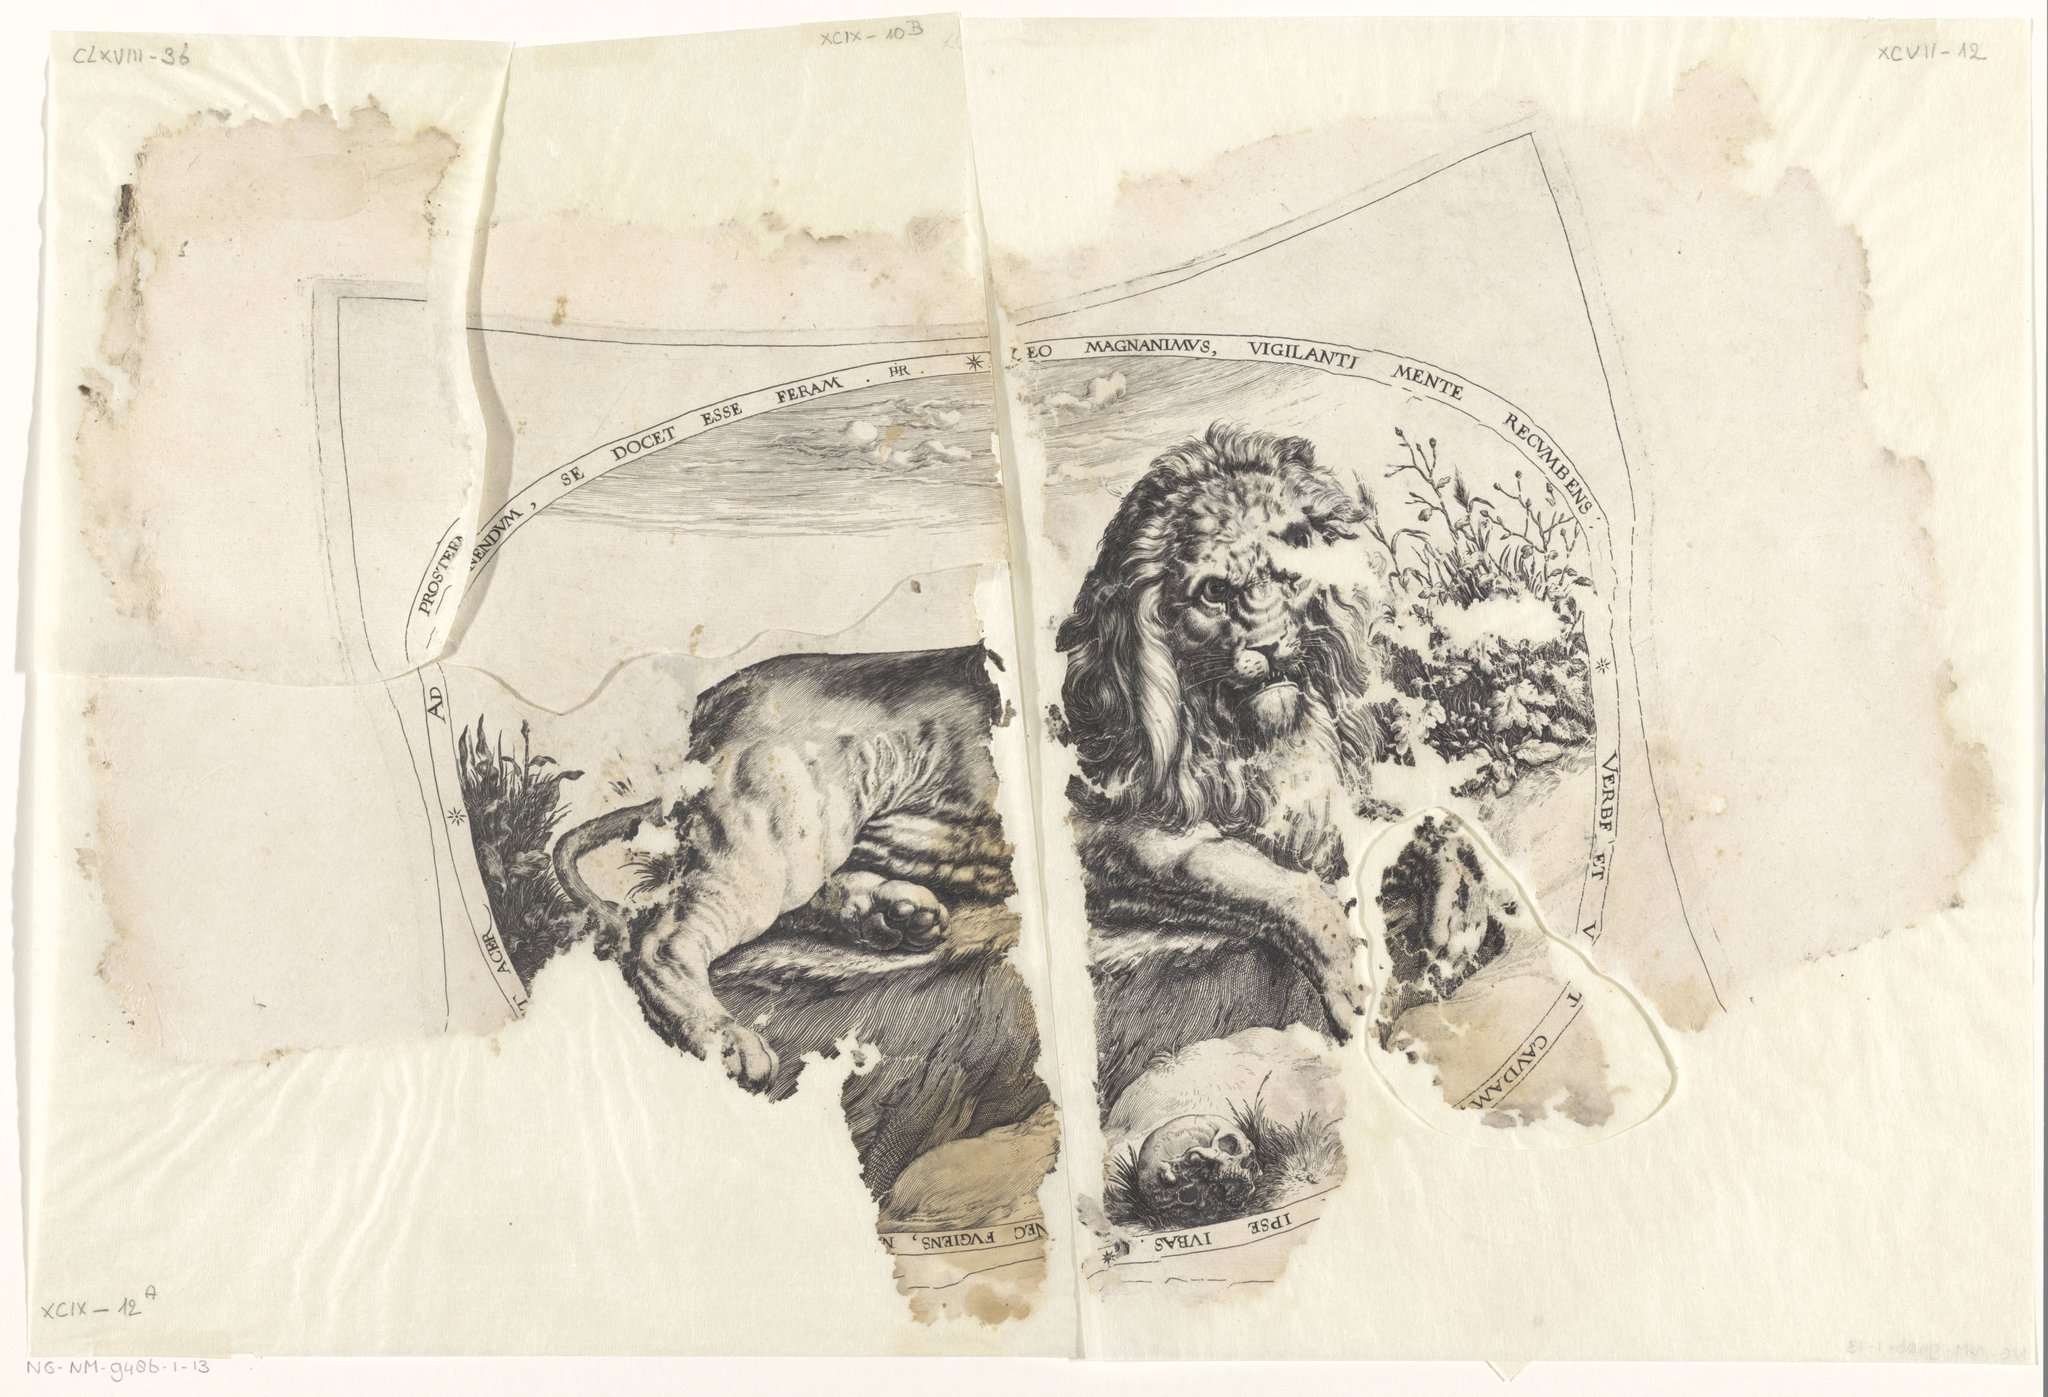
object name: print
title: Leeuw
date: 1580-1596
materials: paper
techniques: engraving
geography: northern netherlands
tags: beasts of prey, predatory animals: lion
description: De prenten in de Nova Zembla collectie zijn tijdens een expeditie van Willem Barendsz en Jacob van Heemskerk in 1596-1597 noodgedwongen in het winterkamp, het ‘Behouden Huis’, op het eiland achtergelaten. De prenten waren in één of meerdere stapels als handelswaar meegenomen vanuit Amsterdam. Bijna drie eeuwen later, in 1871, keerde de Noor Elling Carlsen terug naar Nova Zembla en vond daar de restanten van het ‘Behouden Huis, inclusief een groot deel van de inventaris. Een deel van de prenten, in de vorm van aaneengekoekte kluiten, werd toen ook teruggevonden. De papierkluiten waren soms op meerdere plekken gebroken. Tussen 1975-1979 zijn de prenten van elkaar gescheiden. Dit leverde in totaal ca. 1000 fragmenten van ca. 400 afdrukken van ca. 150 verschillende prenten op. Voor zover mogelijk zijn de fragmenten samengevoegd en zijn de prenten gereconstrueerd.